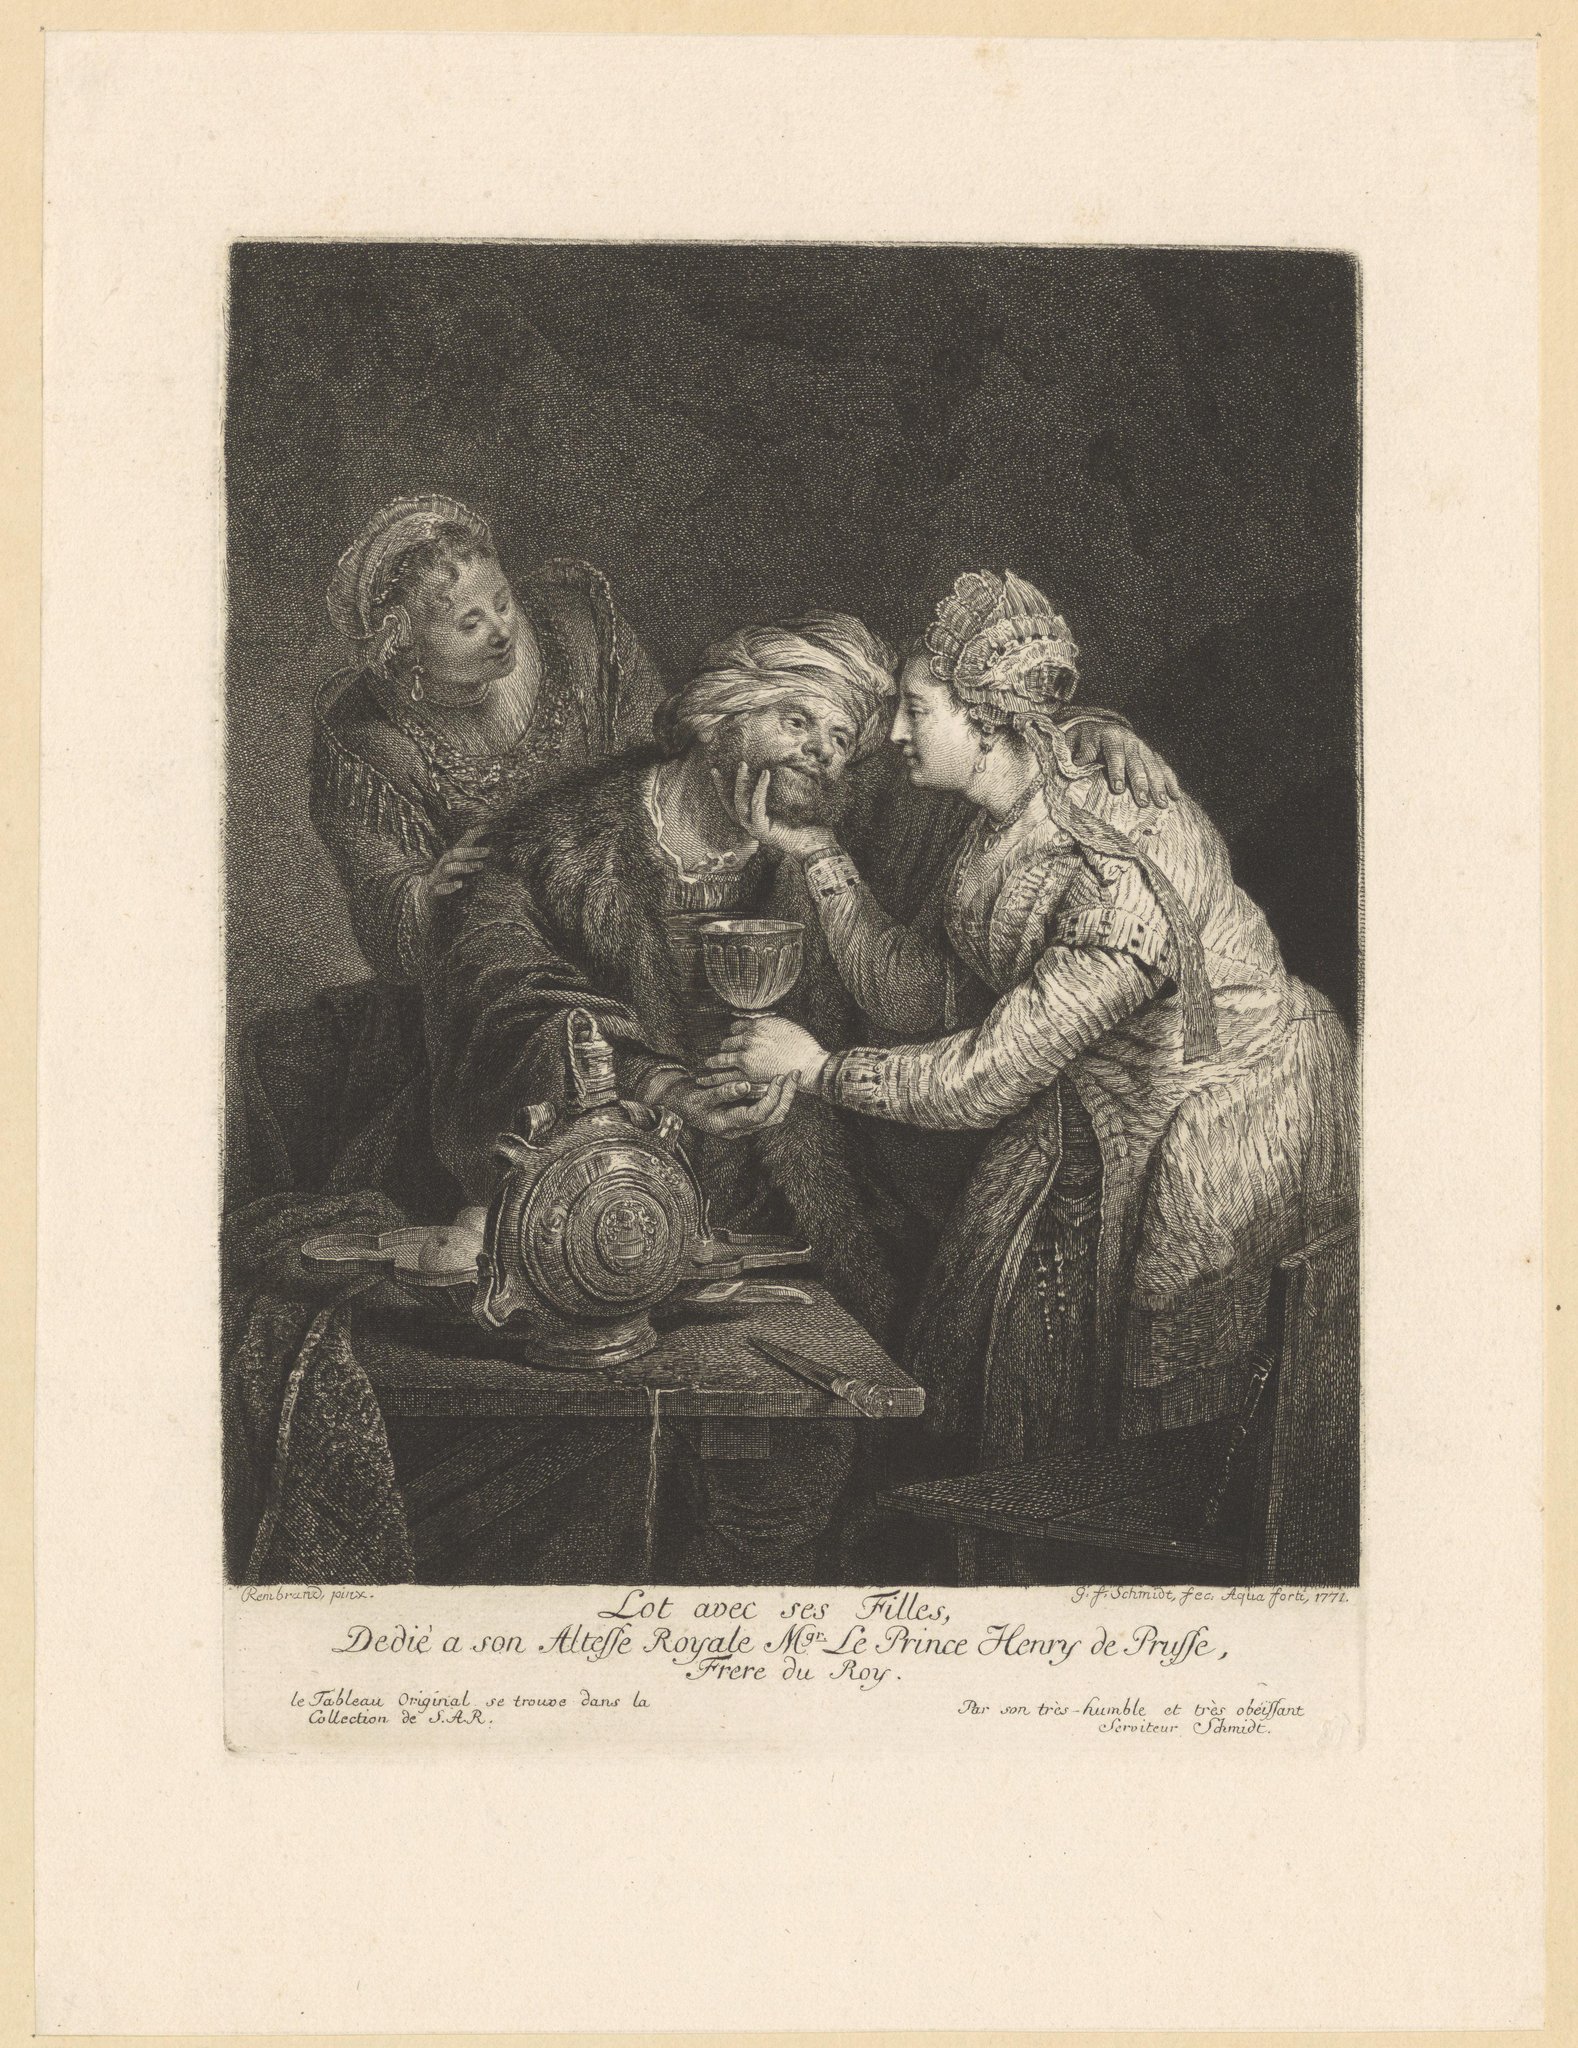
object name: print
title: Lot wordt dronken gevoerd door zijn dochters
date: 1771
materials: paper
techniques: etching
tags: lot's daughters make their father drunk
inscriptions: collector's mark: Lugt 240